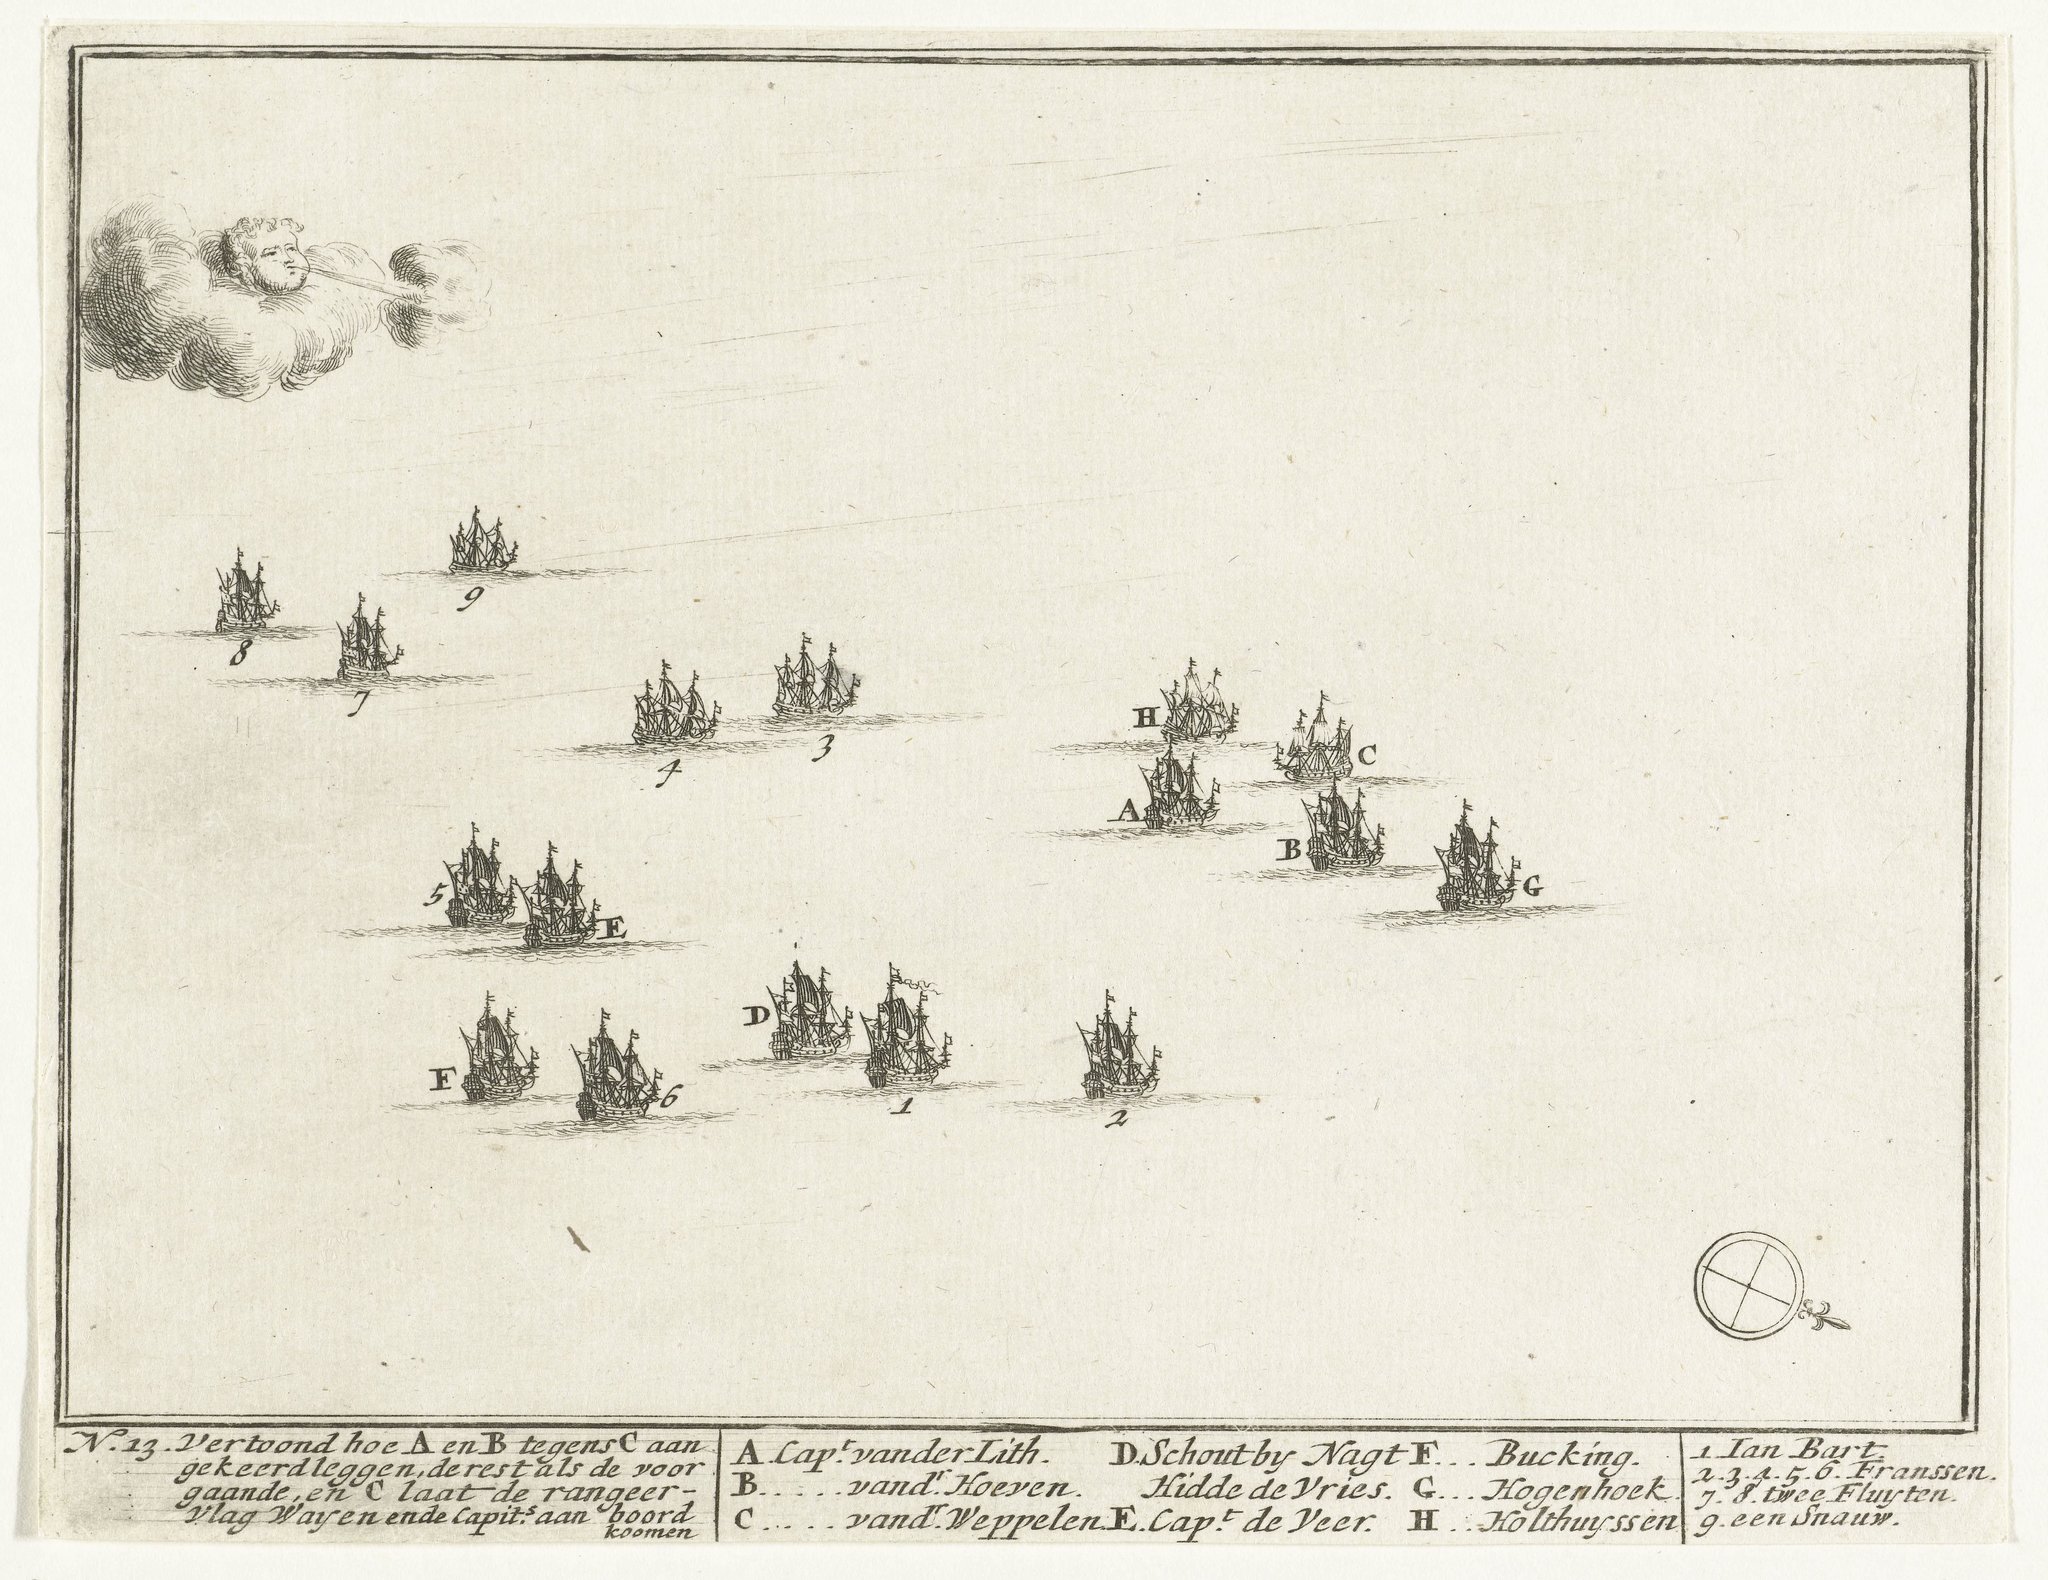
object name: print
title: Zeegevecht tussen Hollanders en Fransen op de Noordzee (plaat 13), 1694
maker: adriaen schoonebeek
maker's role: print maker, publisher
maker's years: 1661-1705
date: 1694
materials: paper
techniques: etching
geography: amsterdam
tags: battle (+ naval force)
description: Zeegevecht tussen Hollanders en Fransen op de Noordzee. Plaat nr. 13 in een serie van 14 genummerde platen van een zeegevecht voorgevallen tussen een Hollands eskader onder Hidde Sjoerds de Vries en Franse schepen onder Jan Bart op de Noordzee, 29 juni 1694.